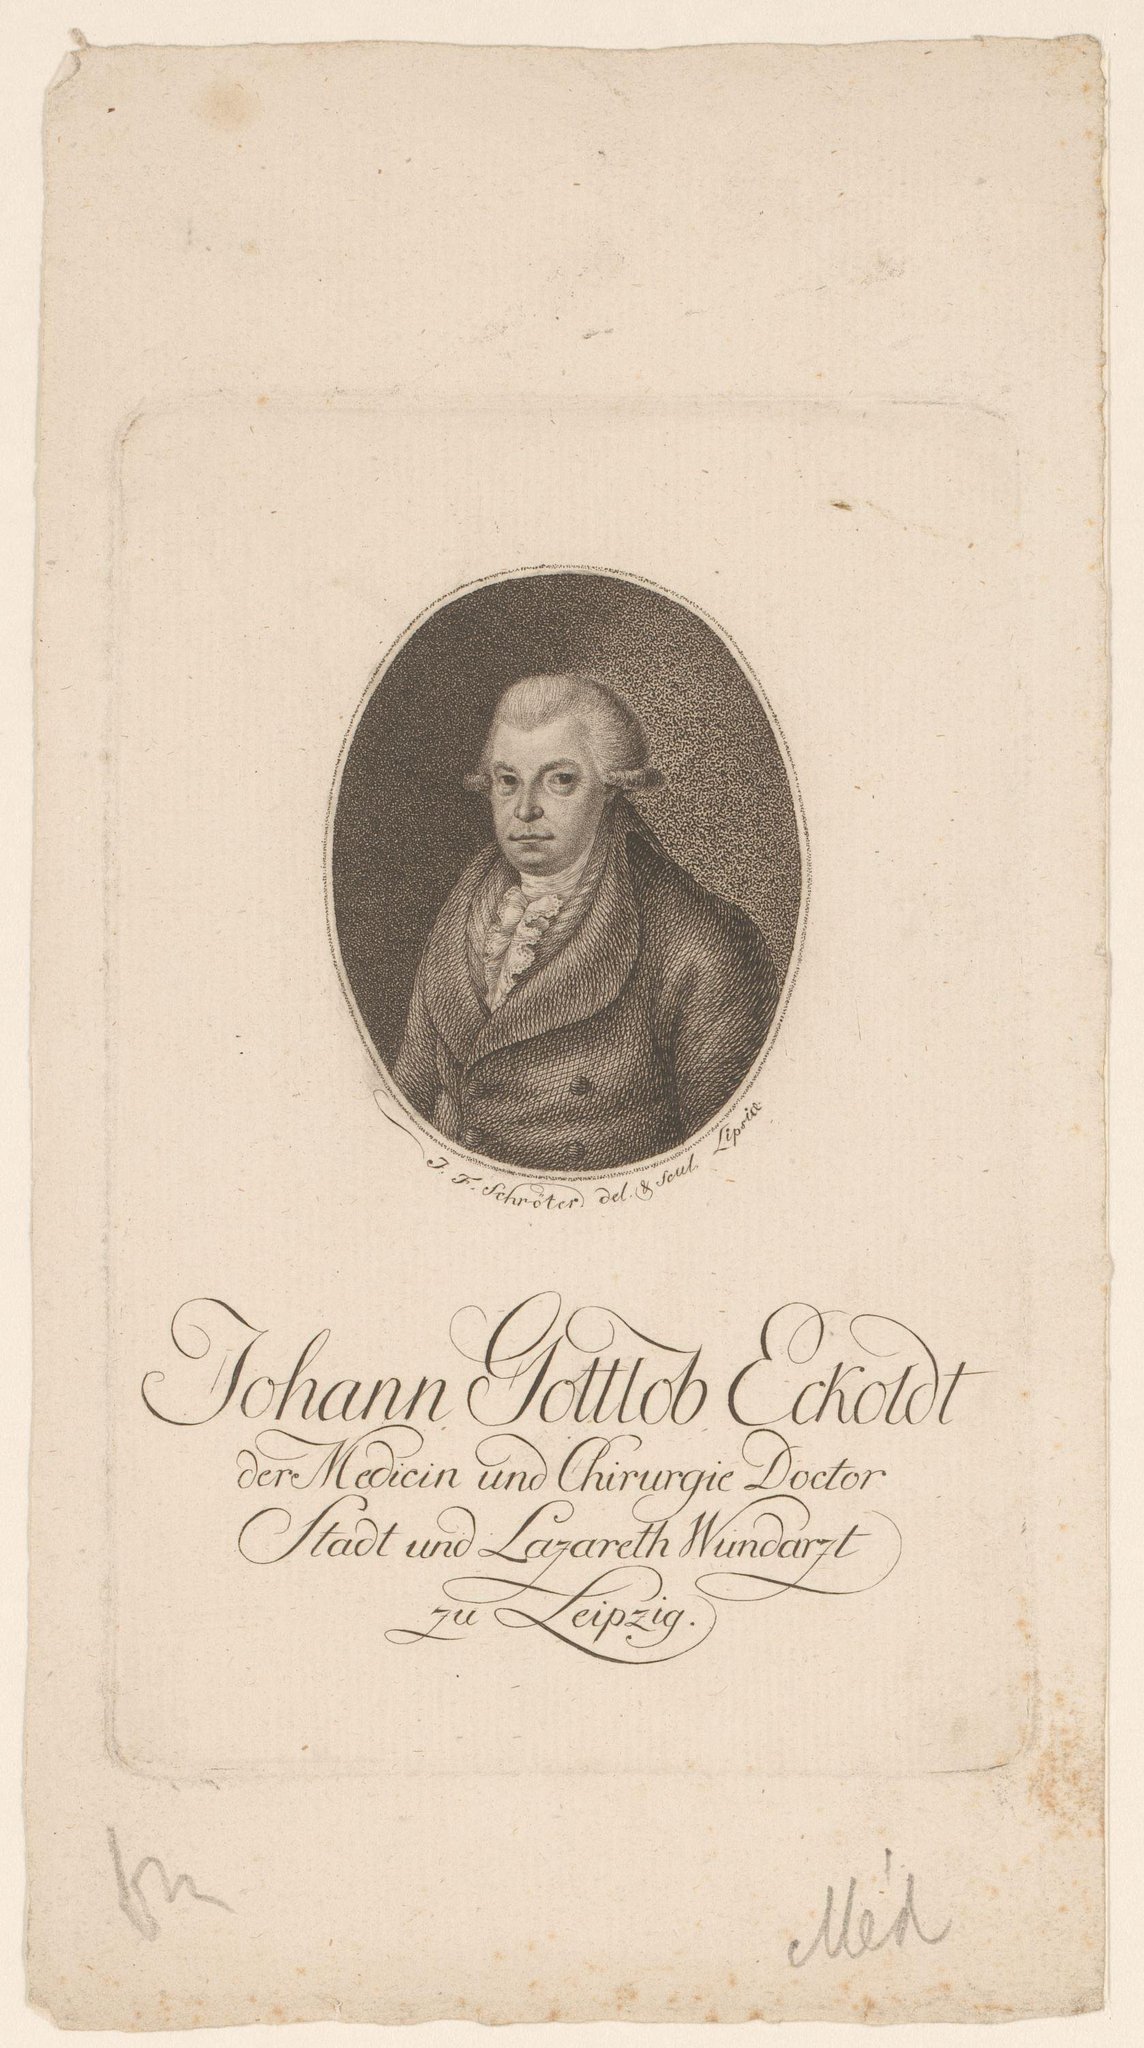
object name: print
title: Portret van Johann Gottlob Eckoldt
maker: johan friedrich schrötter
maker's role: print maker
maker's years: 1770-1836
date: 1780-1836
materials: paper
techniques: engraving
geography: leipzig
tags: historical persons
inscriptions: collector's mark: Lugt 2228